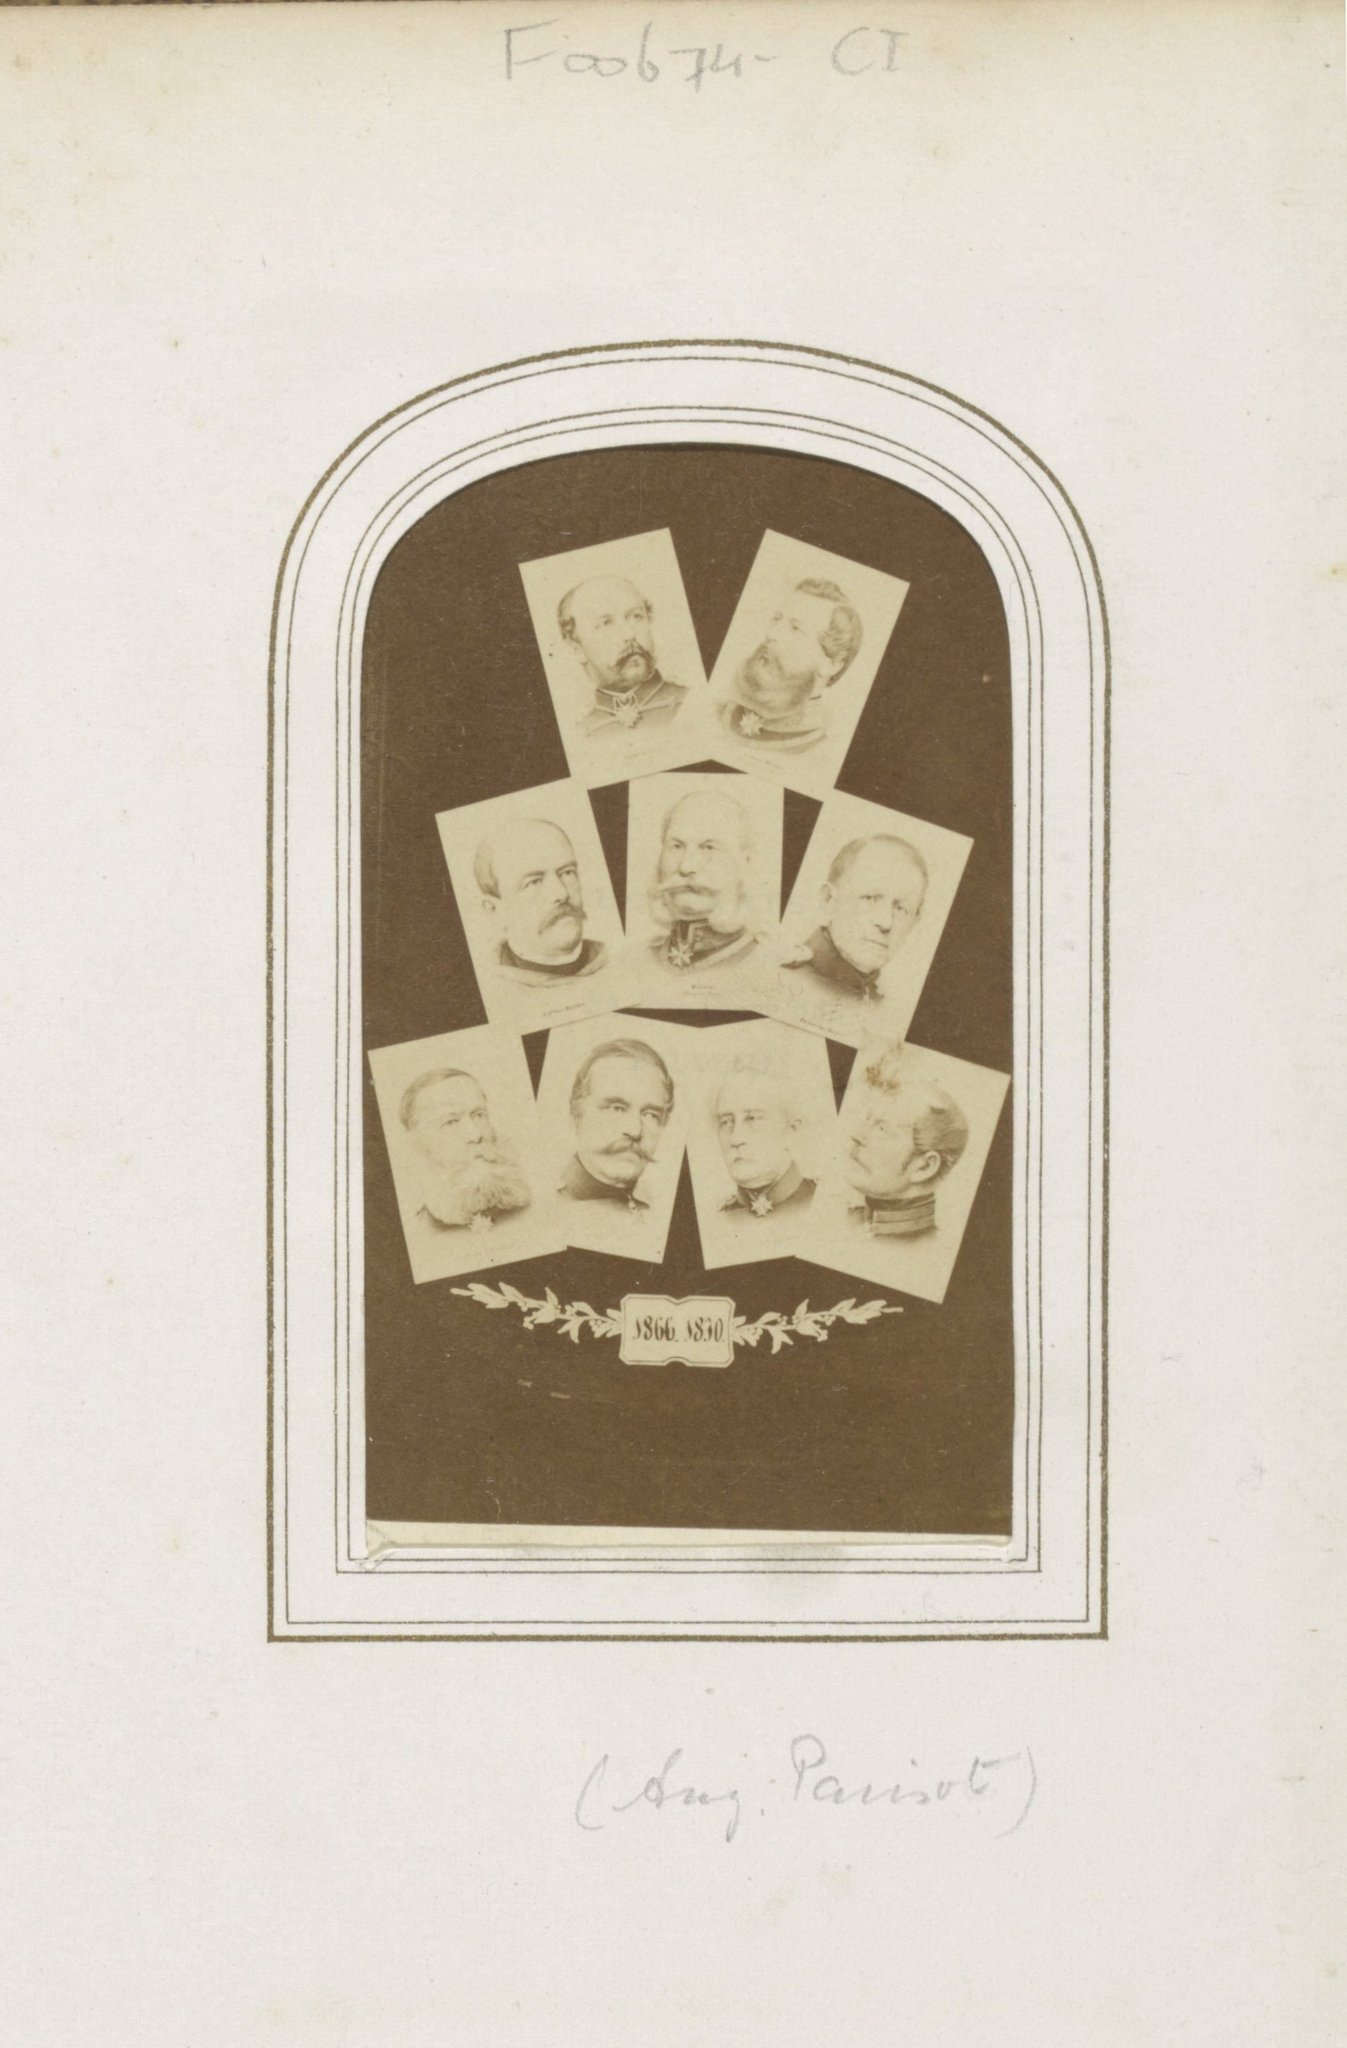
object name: carte de visite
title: Fotocollage van 9 miniatuurportretten van Duitse vorsten, militairen en politici uit de periode 1830-1866, waaronder Otto von Bismarck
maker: aug. parisot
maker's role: fotograaf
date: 1870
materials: cardboard, paper, photographic support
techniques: albumen print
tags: prince, historical persons, politician, e.g. party leader, ruler, sovereign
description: Onderdeel van Fotoalbum met 123 cartes-de-visite van leden van Europese vorstenhuizen, politici en bekende personen.